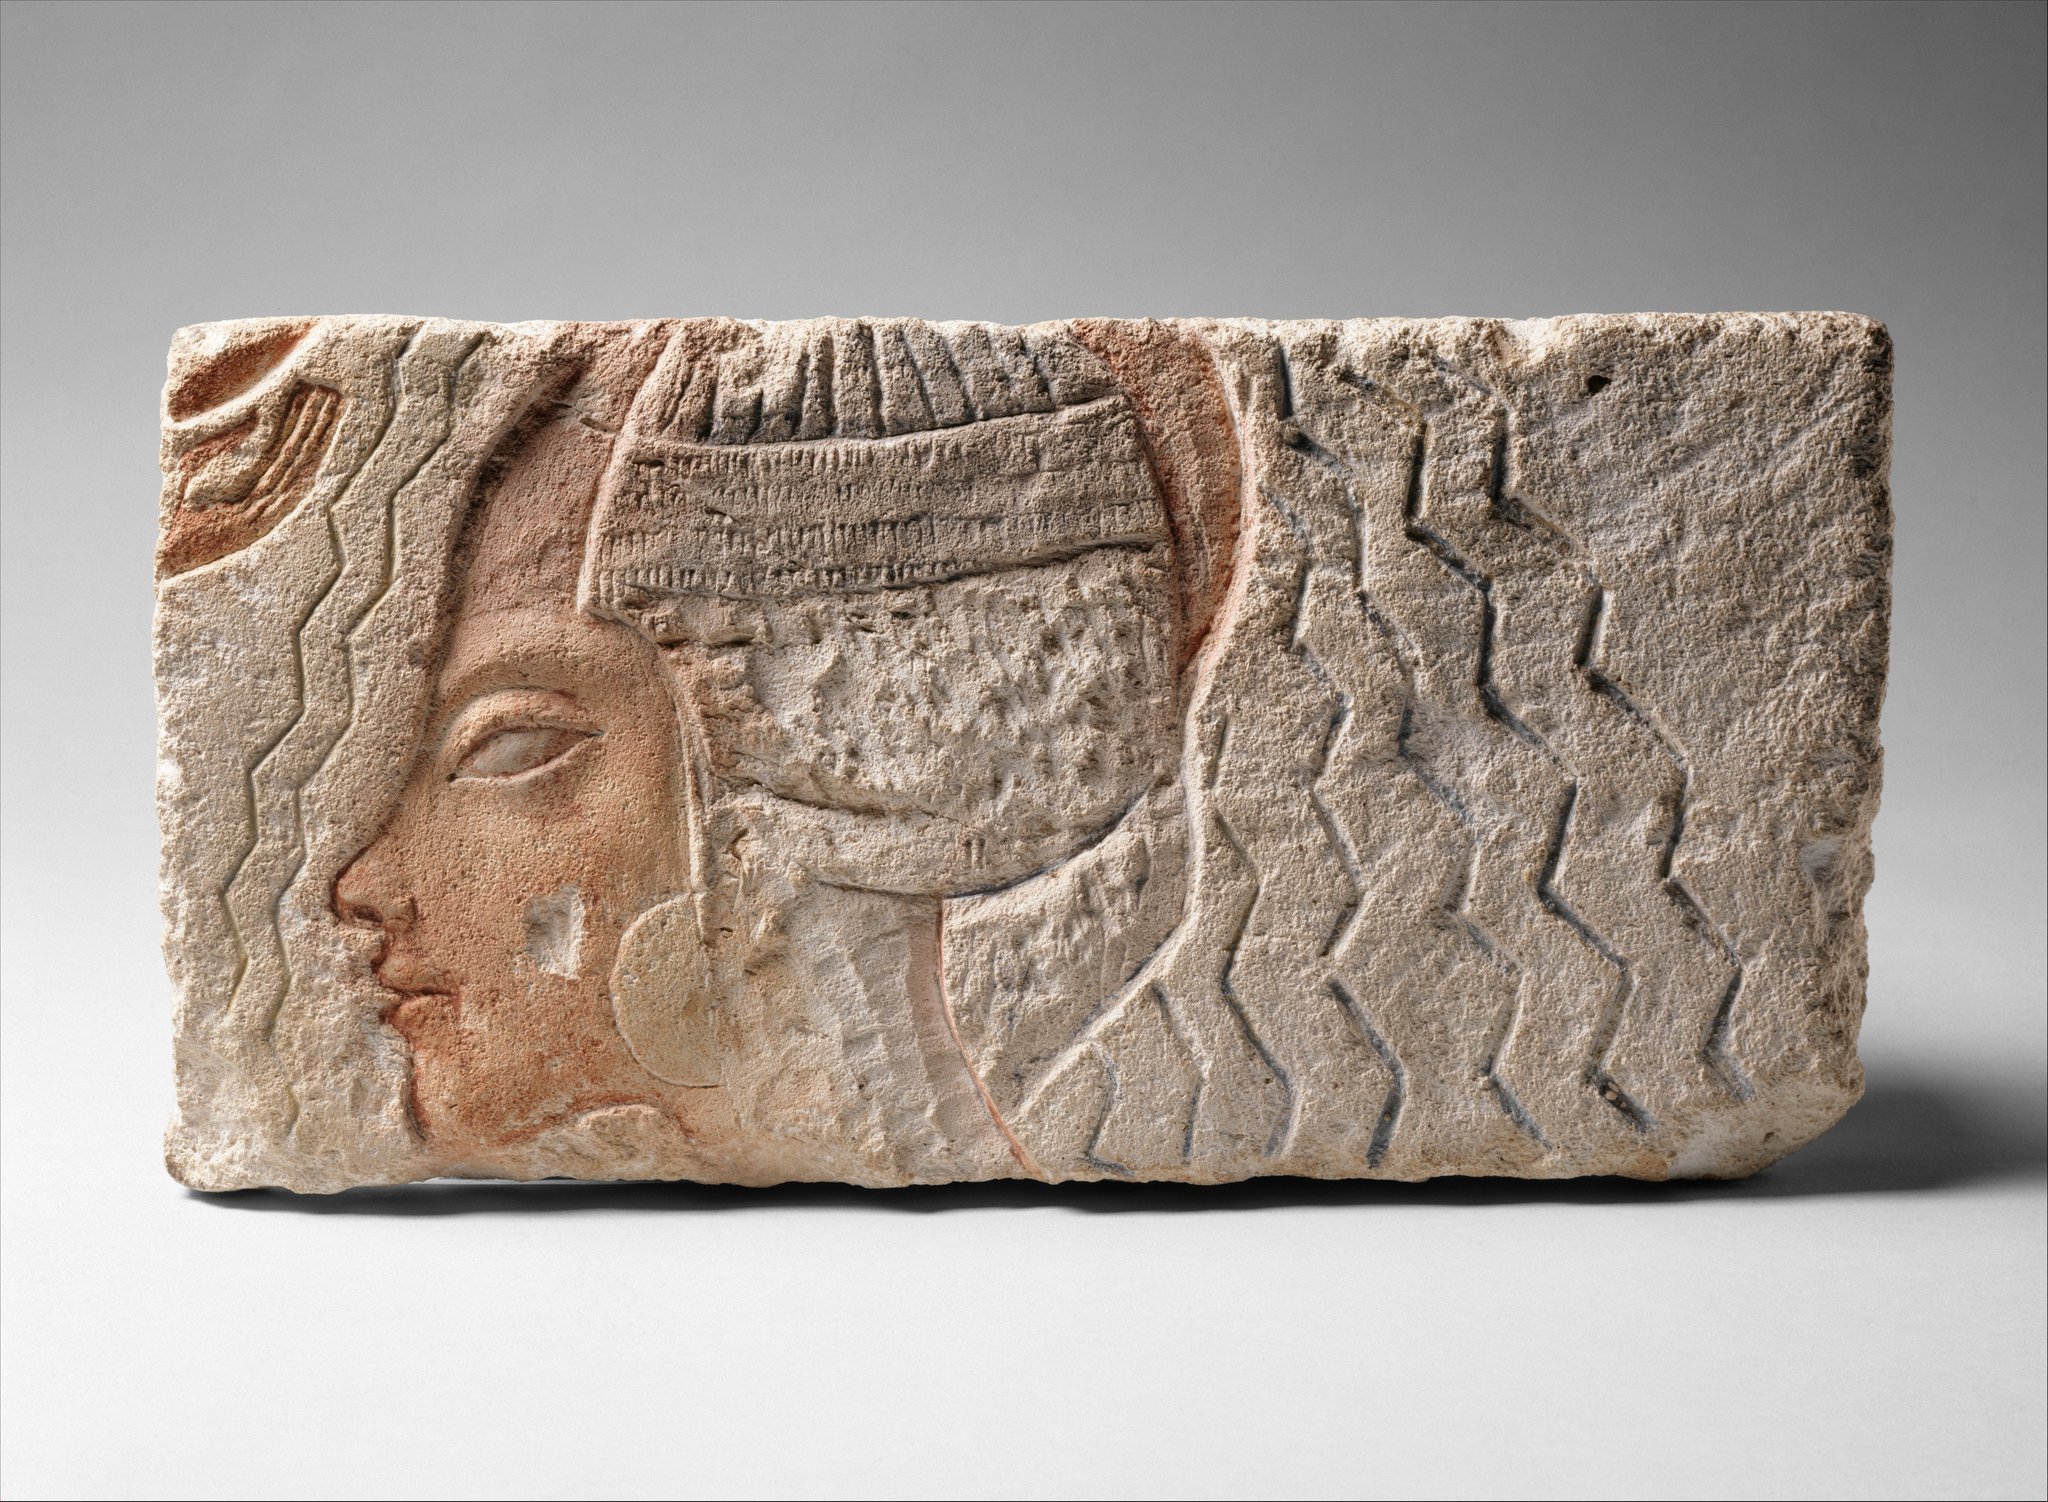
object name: relief, woman, kiya, merytaten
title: Relief Depicting the Purification of Queen Kiya (?)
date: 1353-1336 BCE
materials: limestone, paint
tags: queens